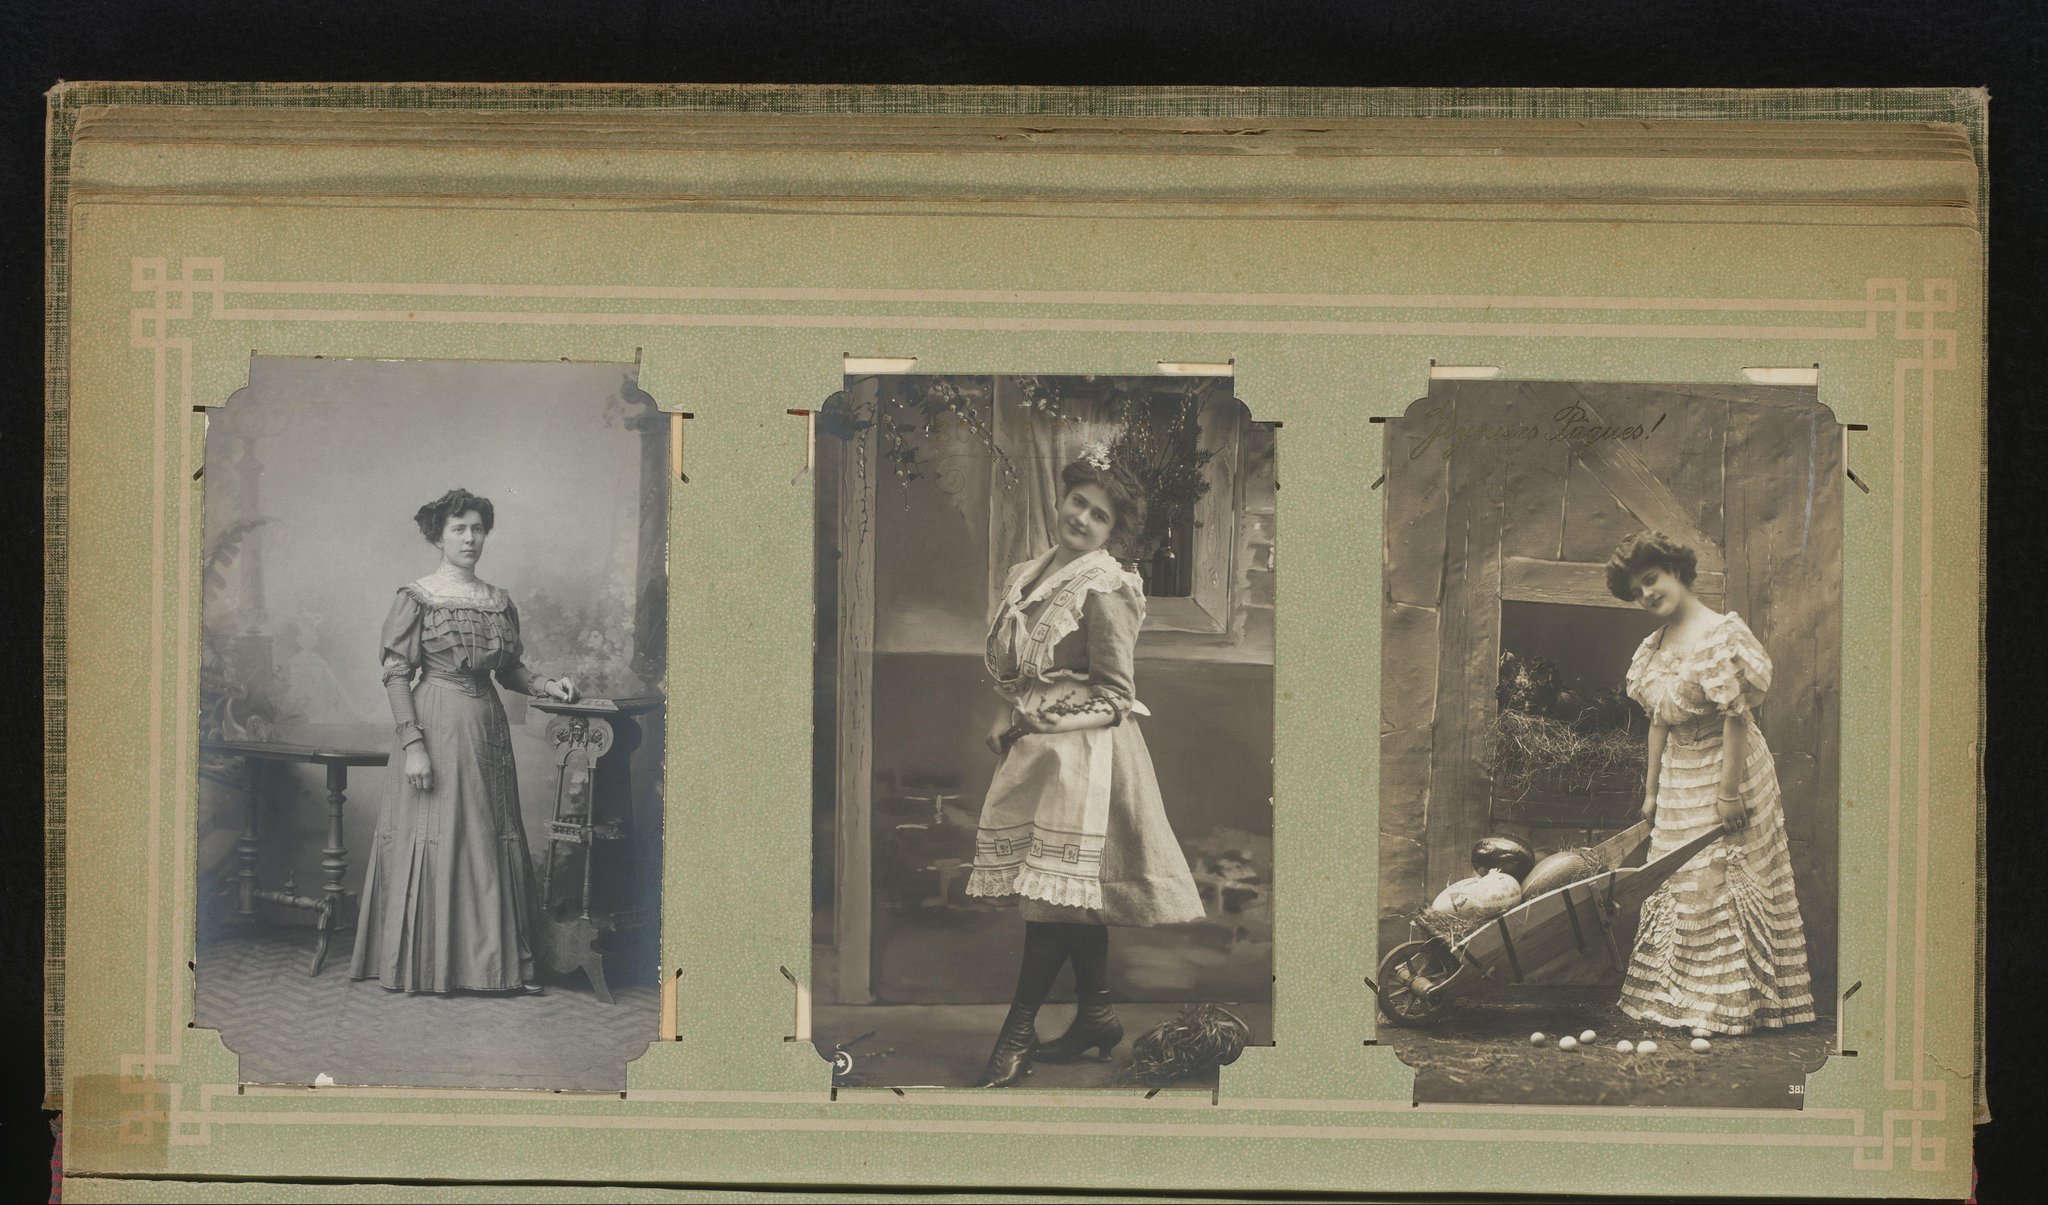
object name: ansichtkaart, prentbriefkaart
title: Drie portretten van jonge vrouwen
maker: Anonymous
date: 1900-1930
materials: cardboard, photographic support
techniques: gelatin silver print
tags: adolescent, young woman, maiden, historical persons - bb - woman, wheelbarrow, standing figure - aa - female human figure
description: Deze foto's maken deel uit van een album.